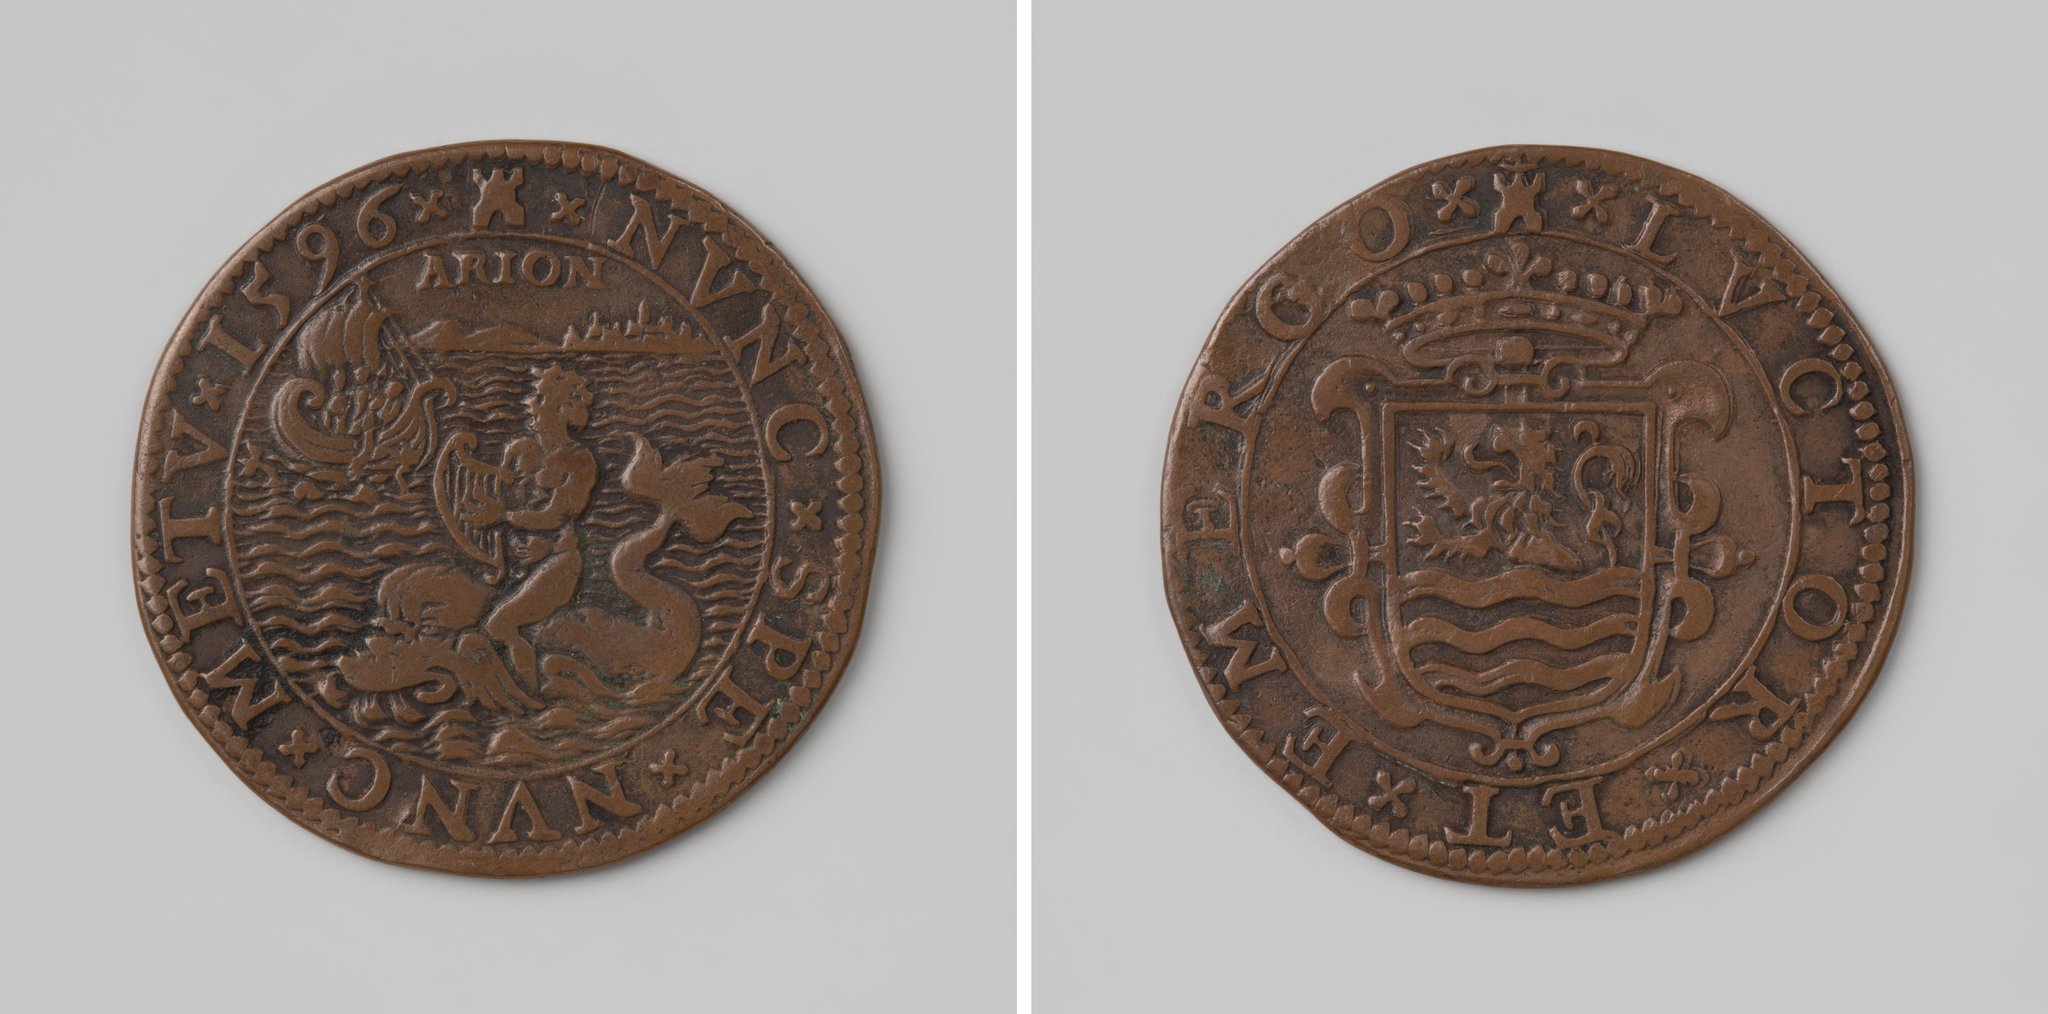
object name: jeton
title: Expansie van de zeevaart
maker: Anonymous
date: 1596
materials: copper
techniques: striking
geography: middelburg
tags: zeeland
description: Koperen penning. Voorzijde: Arion, spelend op luit, gezeten op rug van dolfijn; op achtergrond schip en kust onder opschrift binnen omschrift. Keerzijde: gekroond wapenschild in cartouche binnen omschrift.